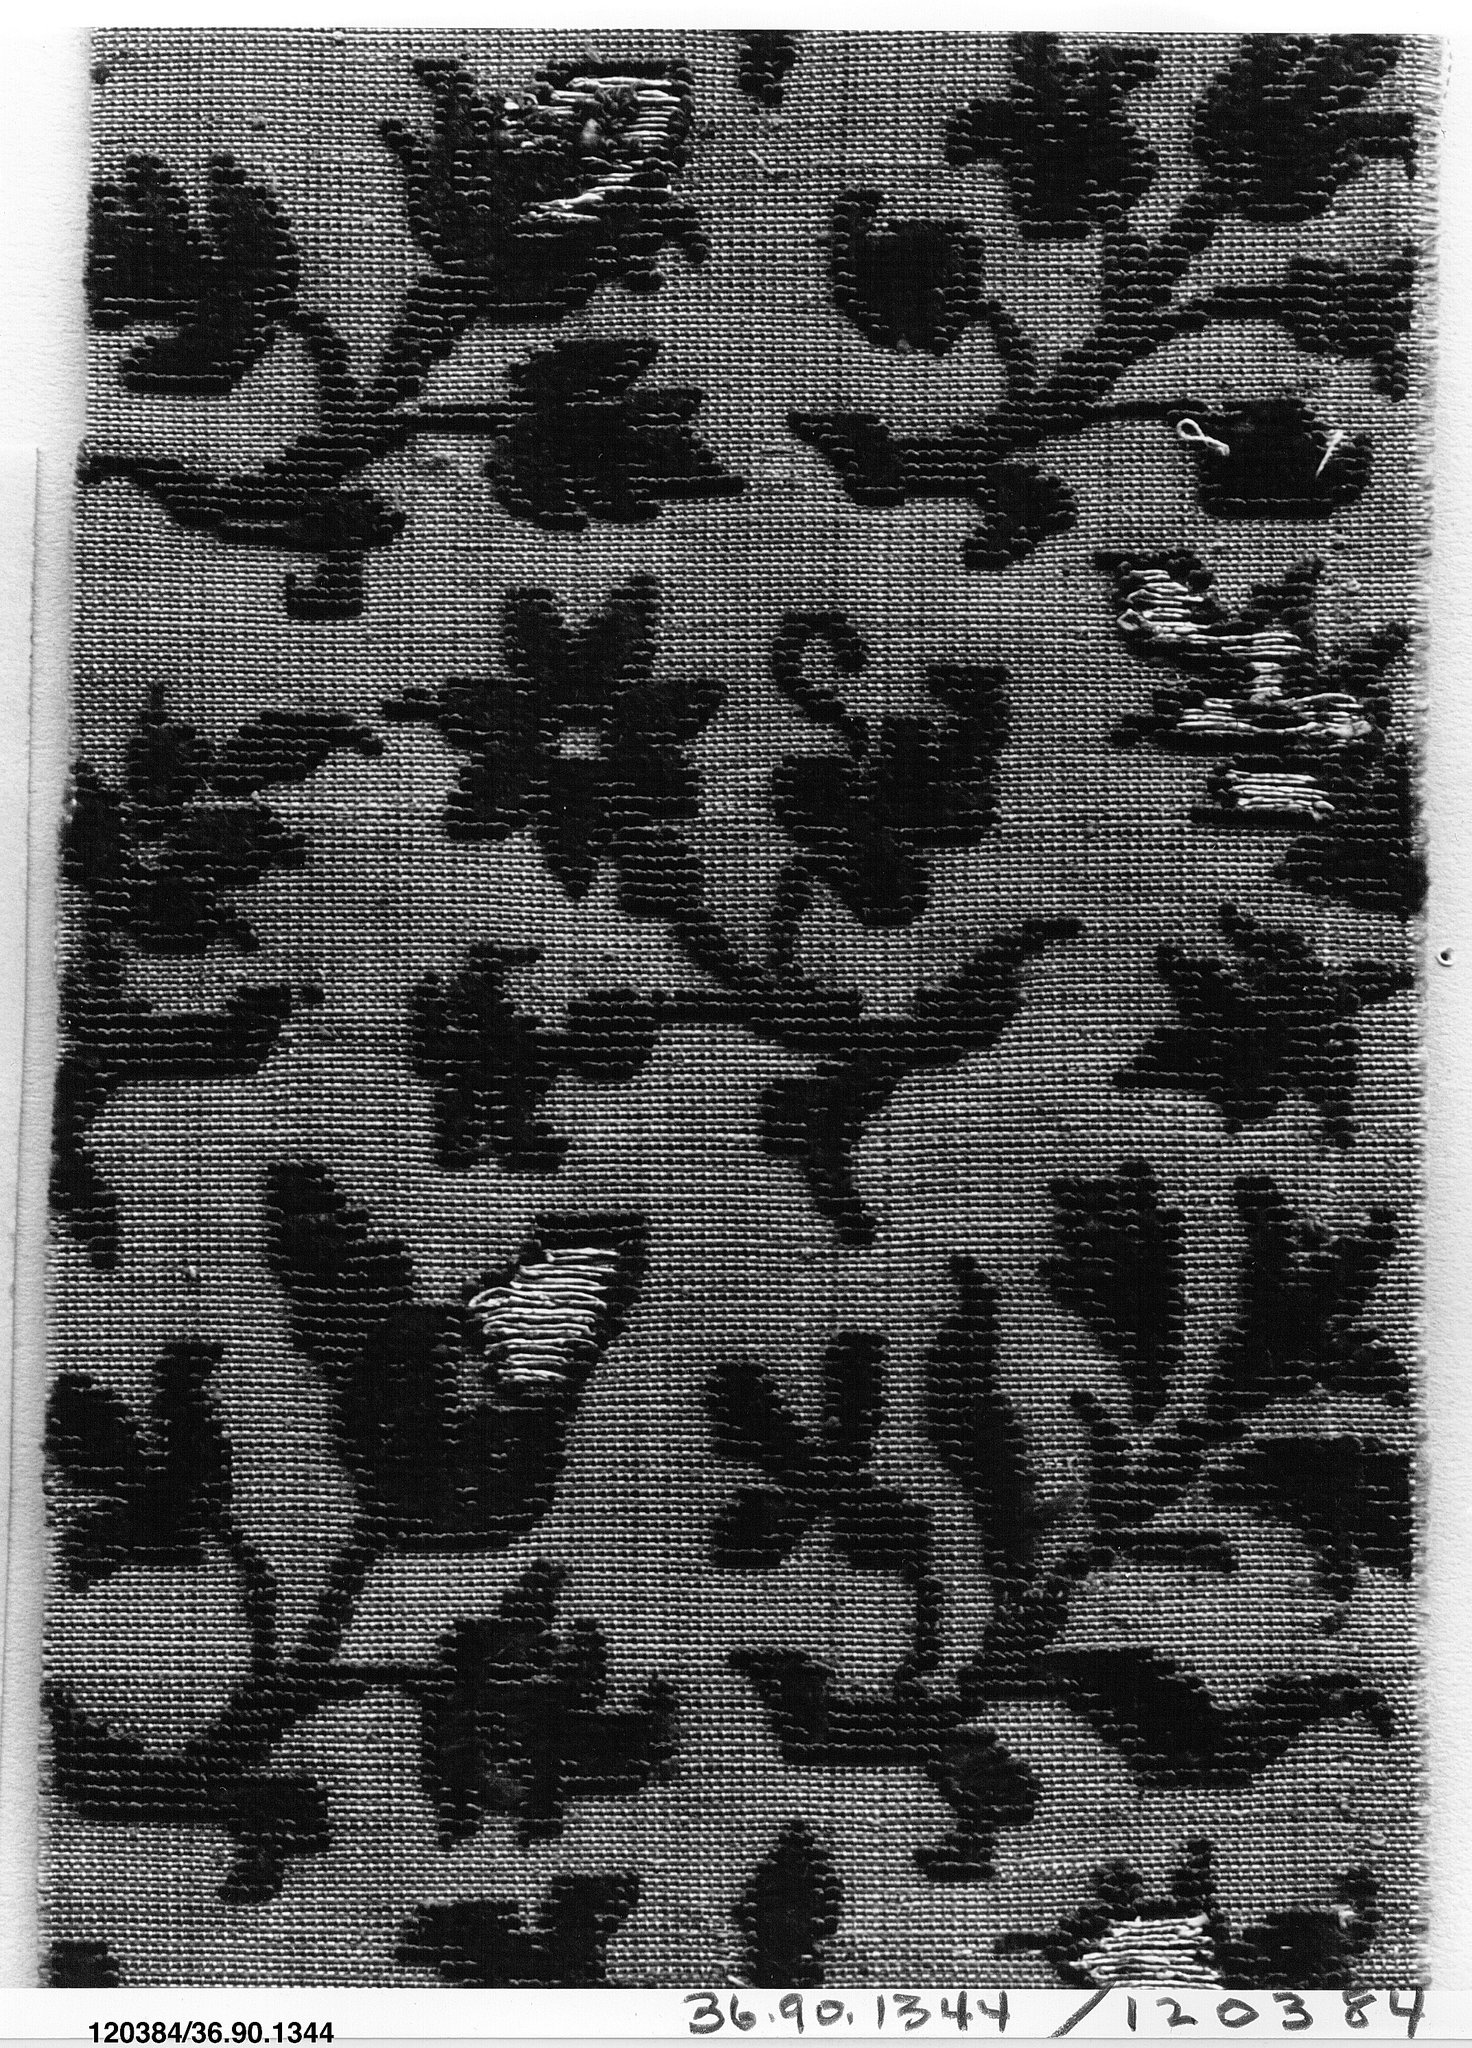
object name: piece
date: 1501-1700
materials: metal thread, silk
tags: flowers,leaves